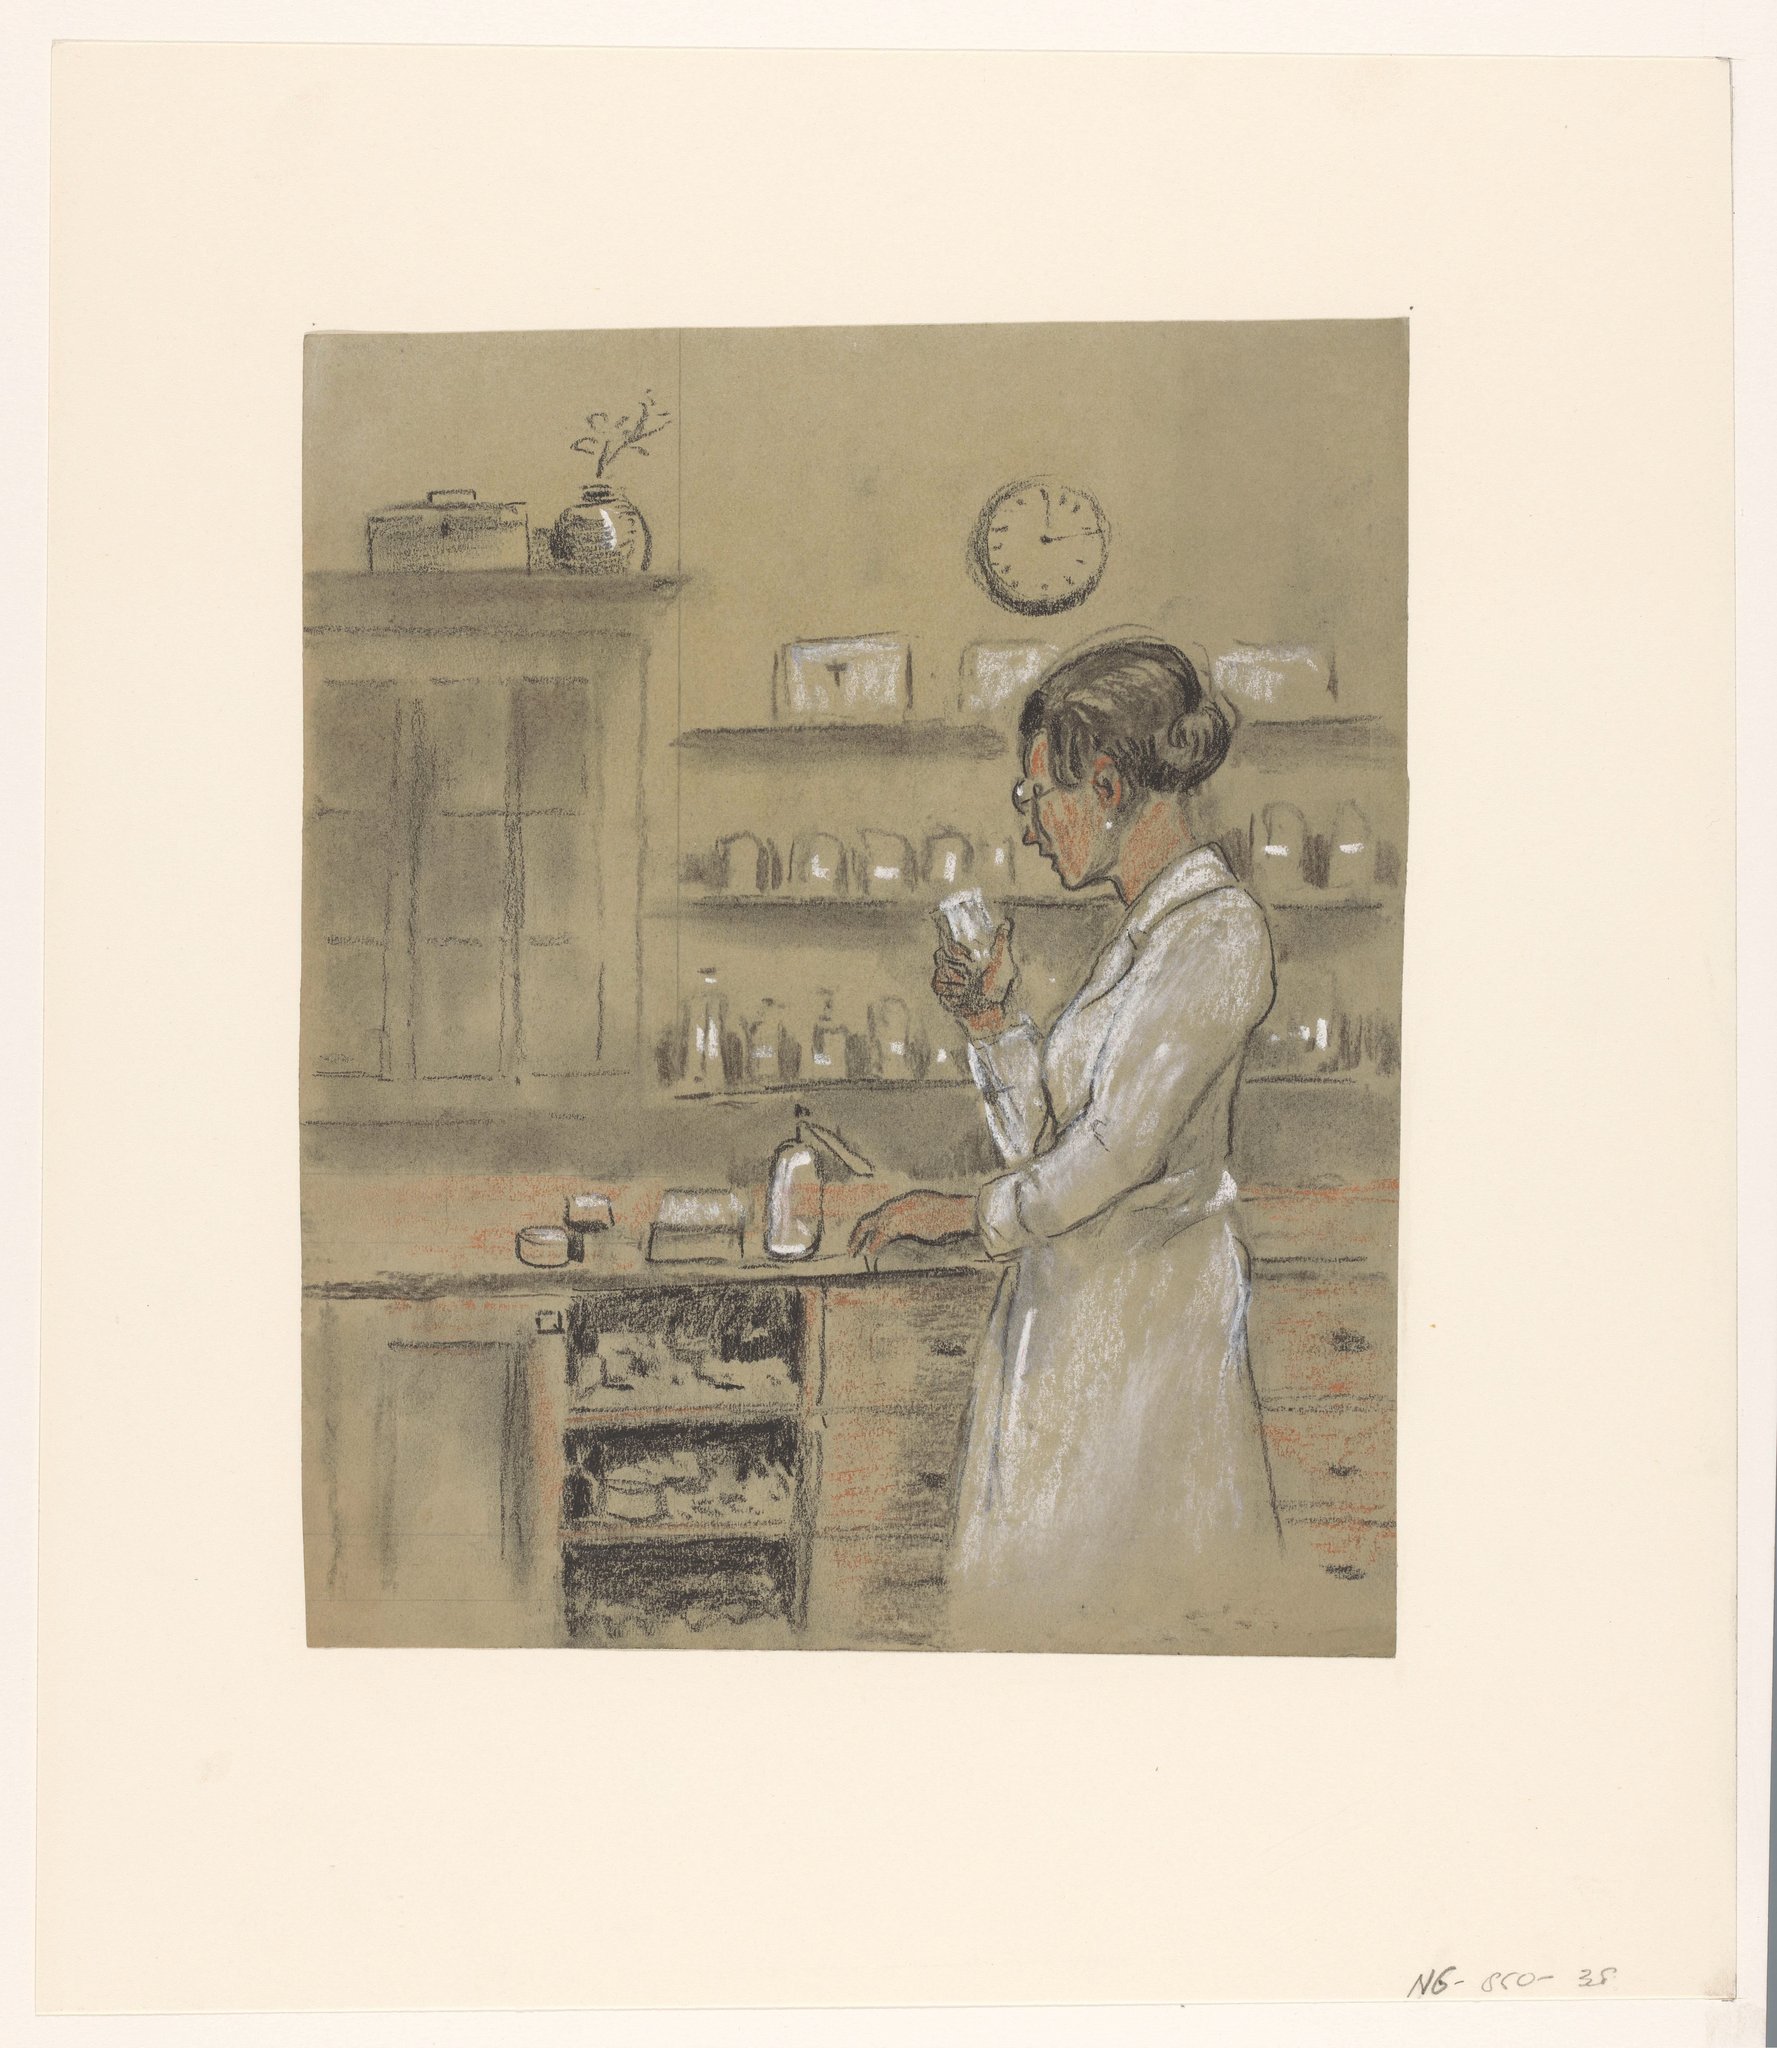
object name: drawing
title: Vrouw in laboratorium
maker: herman heijenbrock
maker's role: draughtsman, painter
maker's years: 1871-1948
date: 1900-1925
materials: chalk, paper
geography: netherlands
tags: laboratory (+ woman als scholar oe scientist), laboratory, research room, laboratory, netherlands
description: Staande vrouw in een scheikundig laboratorium, in witte laboratoriumjas met bril, naar links, linkerhand op tafelblad en rechterhand geheven met een glazen bekertje. Boven haar hoofd een wandklok.